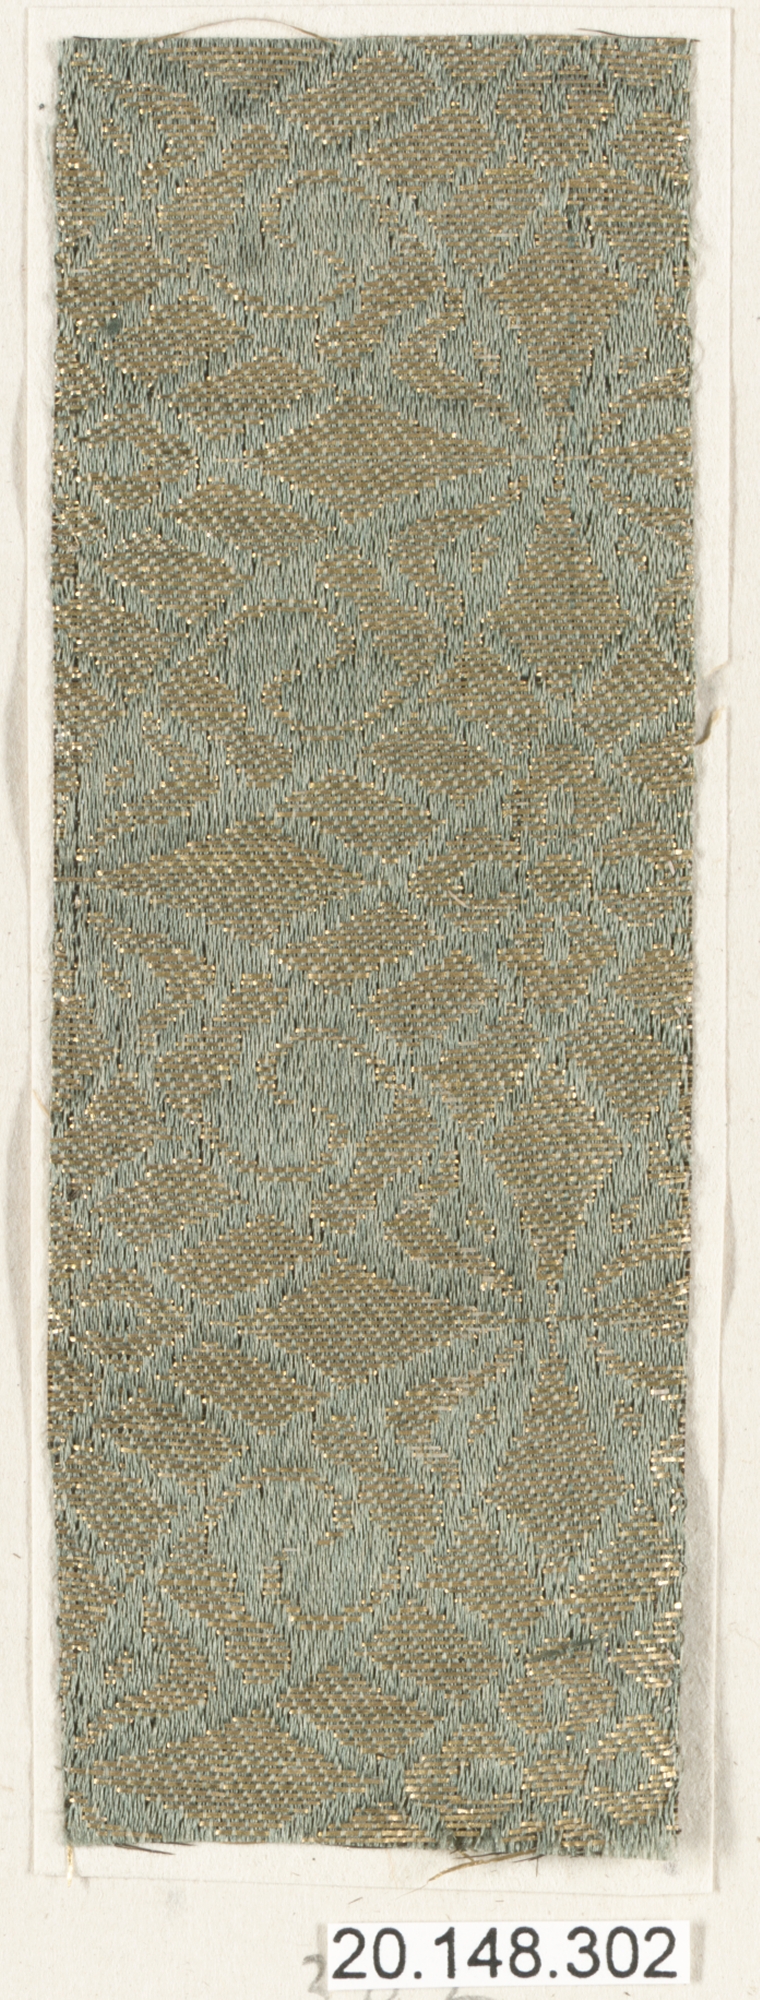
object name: piece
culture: japanese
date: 1701-1800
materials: silk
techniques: compound weave